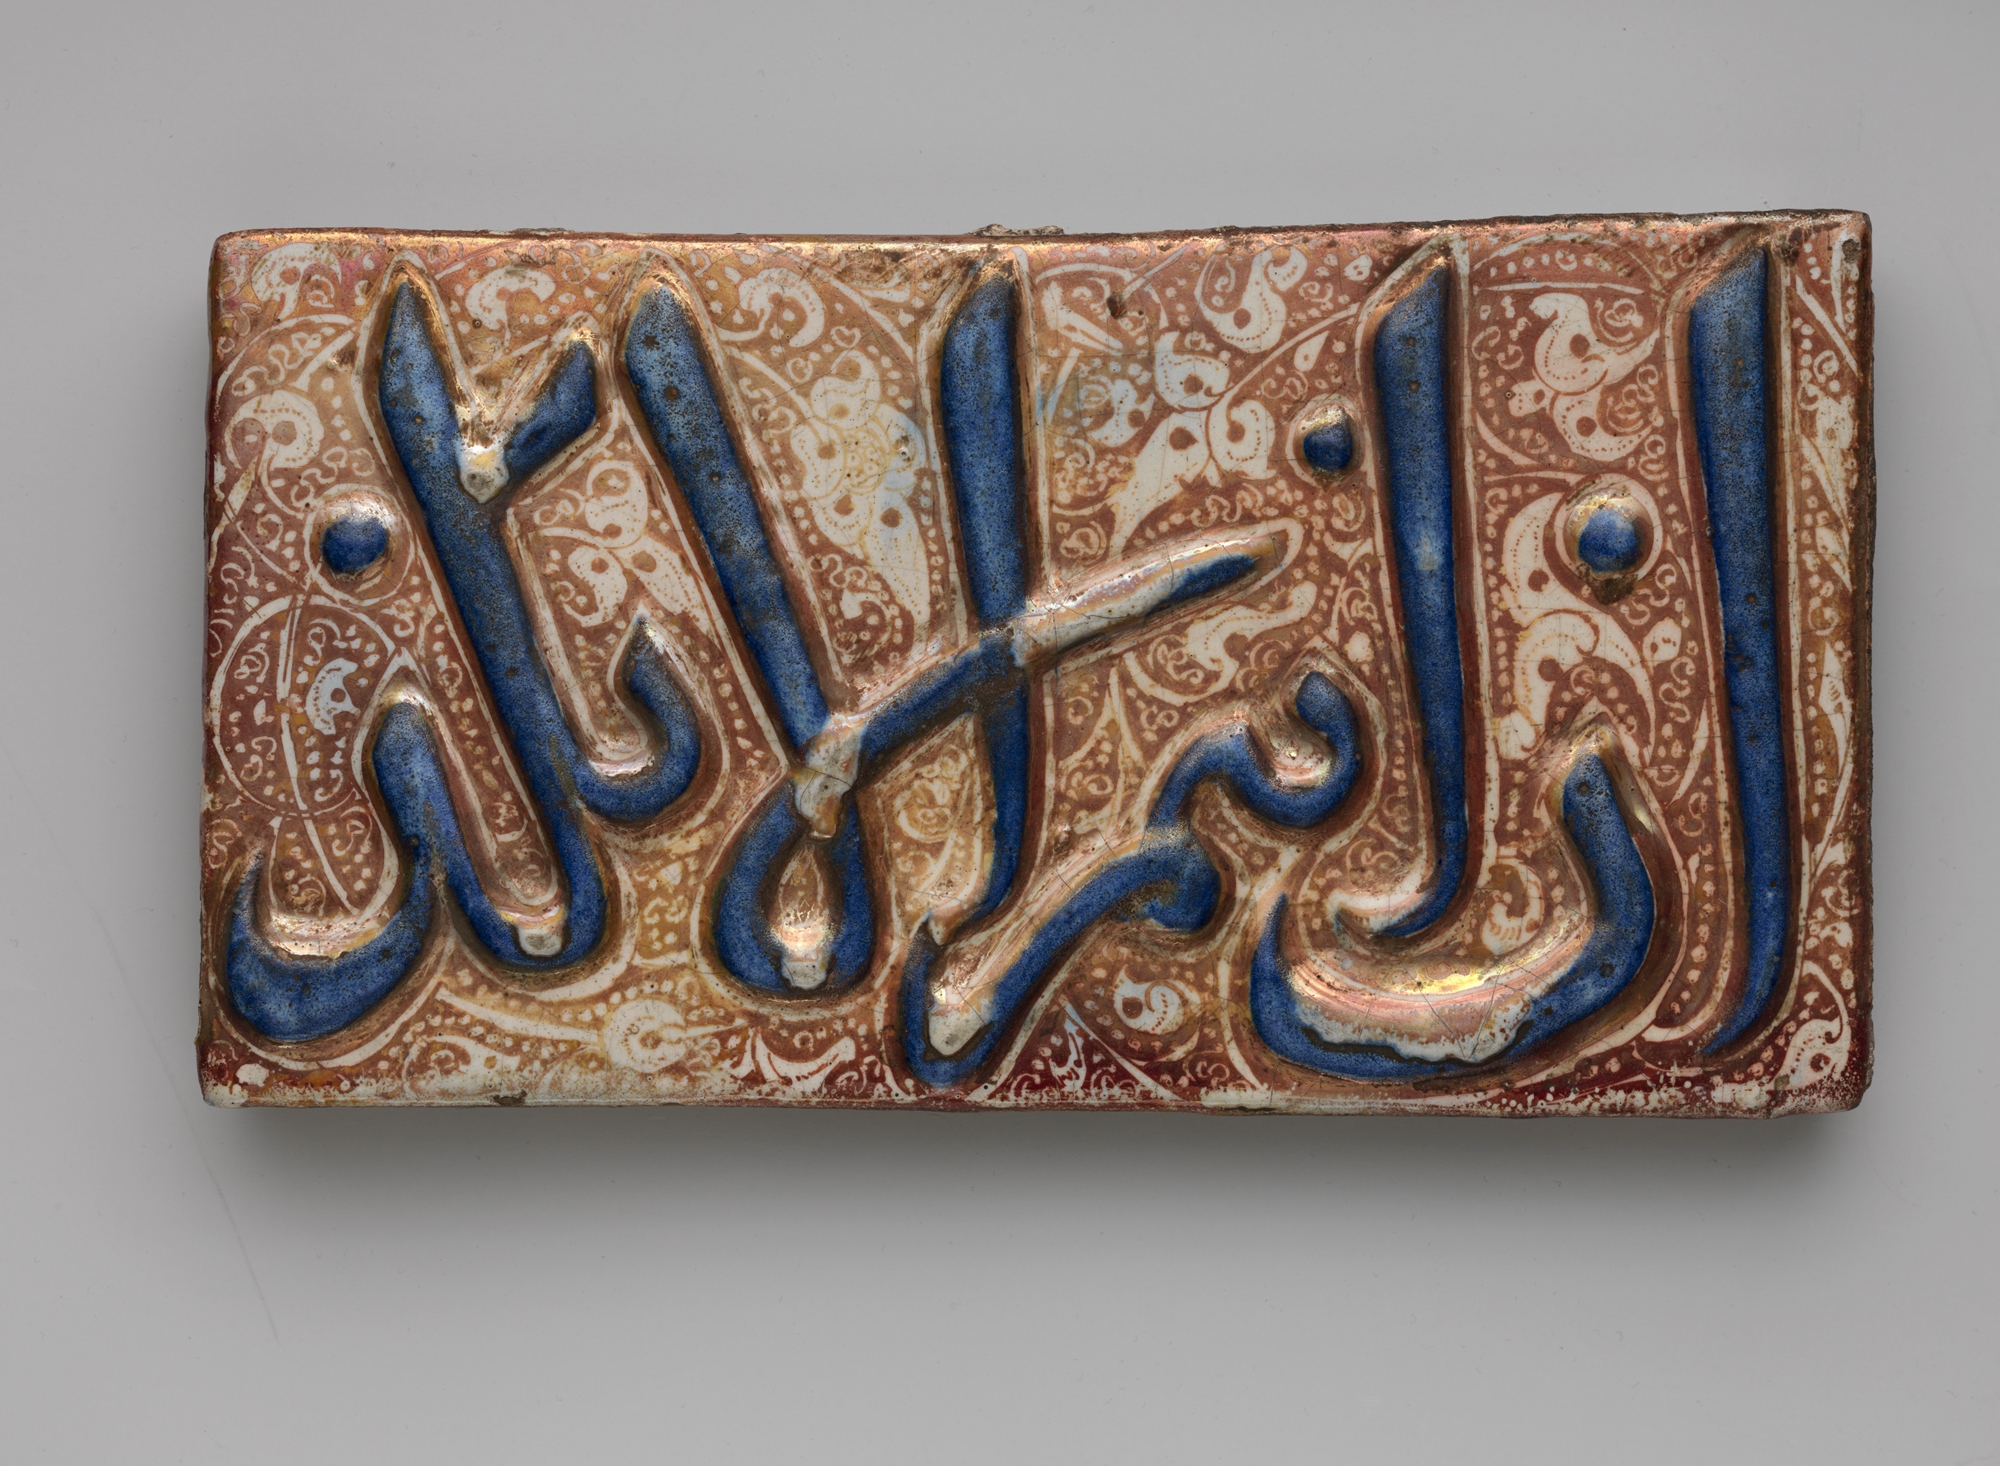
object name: tile panel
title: Pair of Tiles with Qur'anic Inscription from Sura 36 (Ya-Sin): 9 and 15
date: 1251-1300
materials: glaze, stonepaste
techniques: luster painting, molding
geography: iran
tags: qur'an